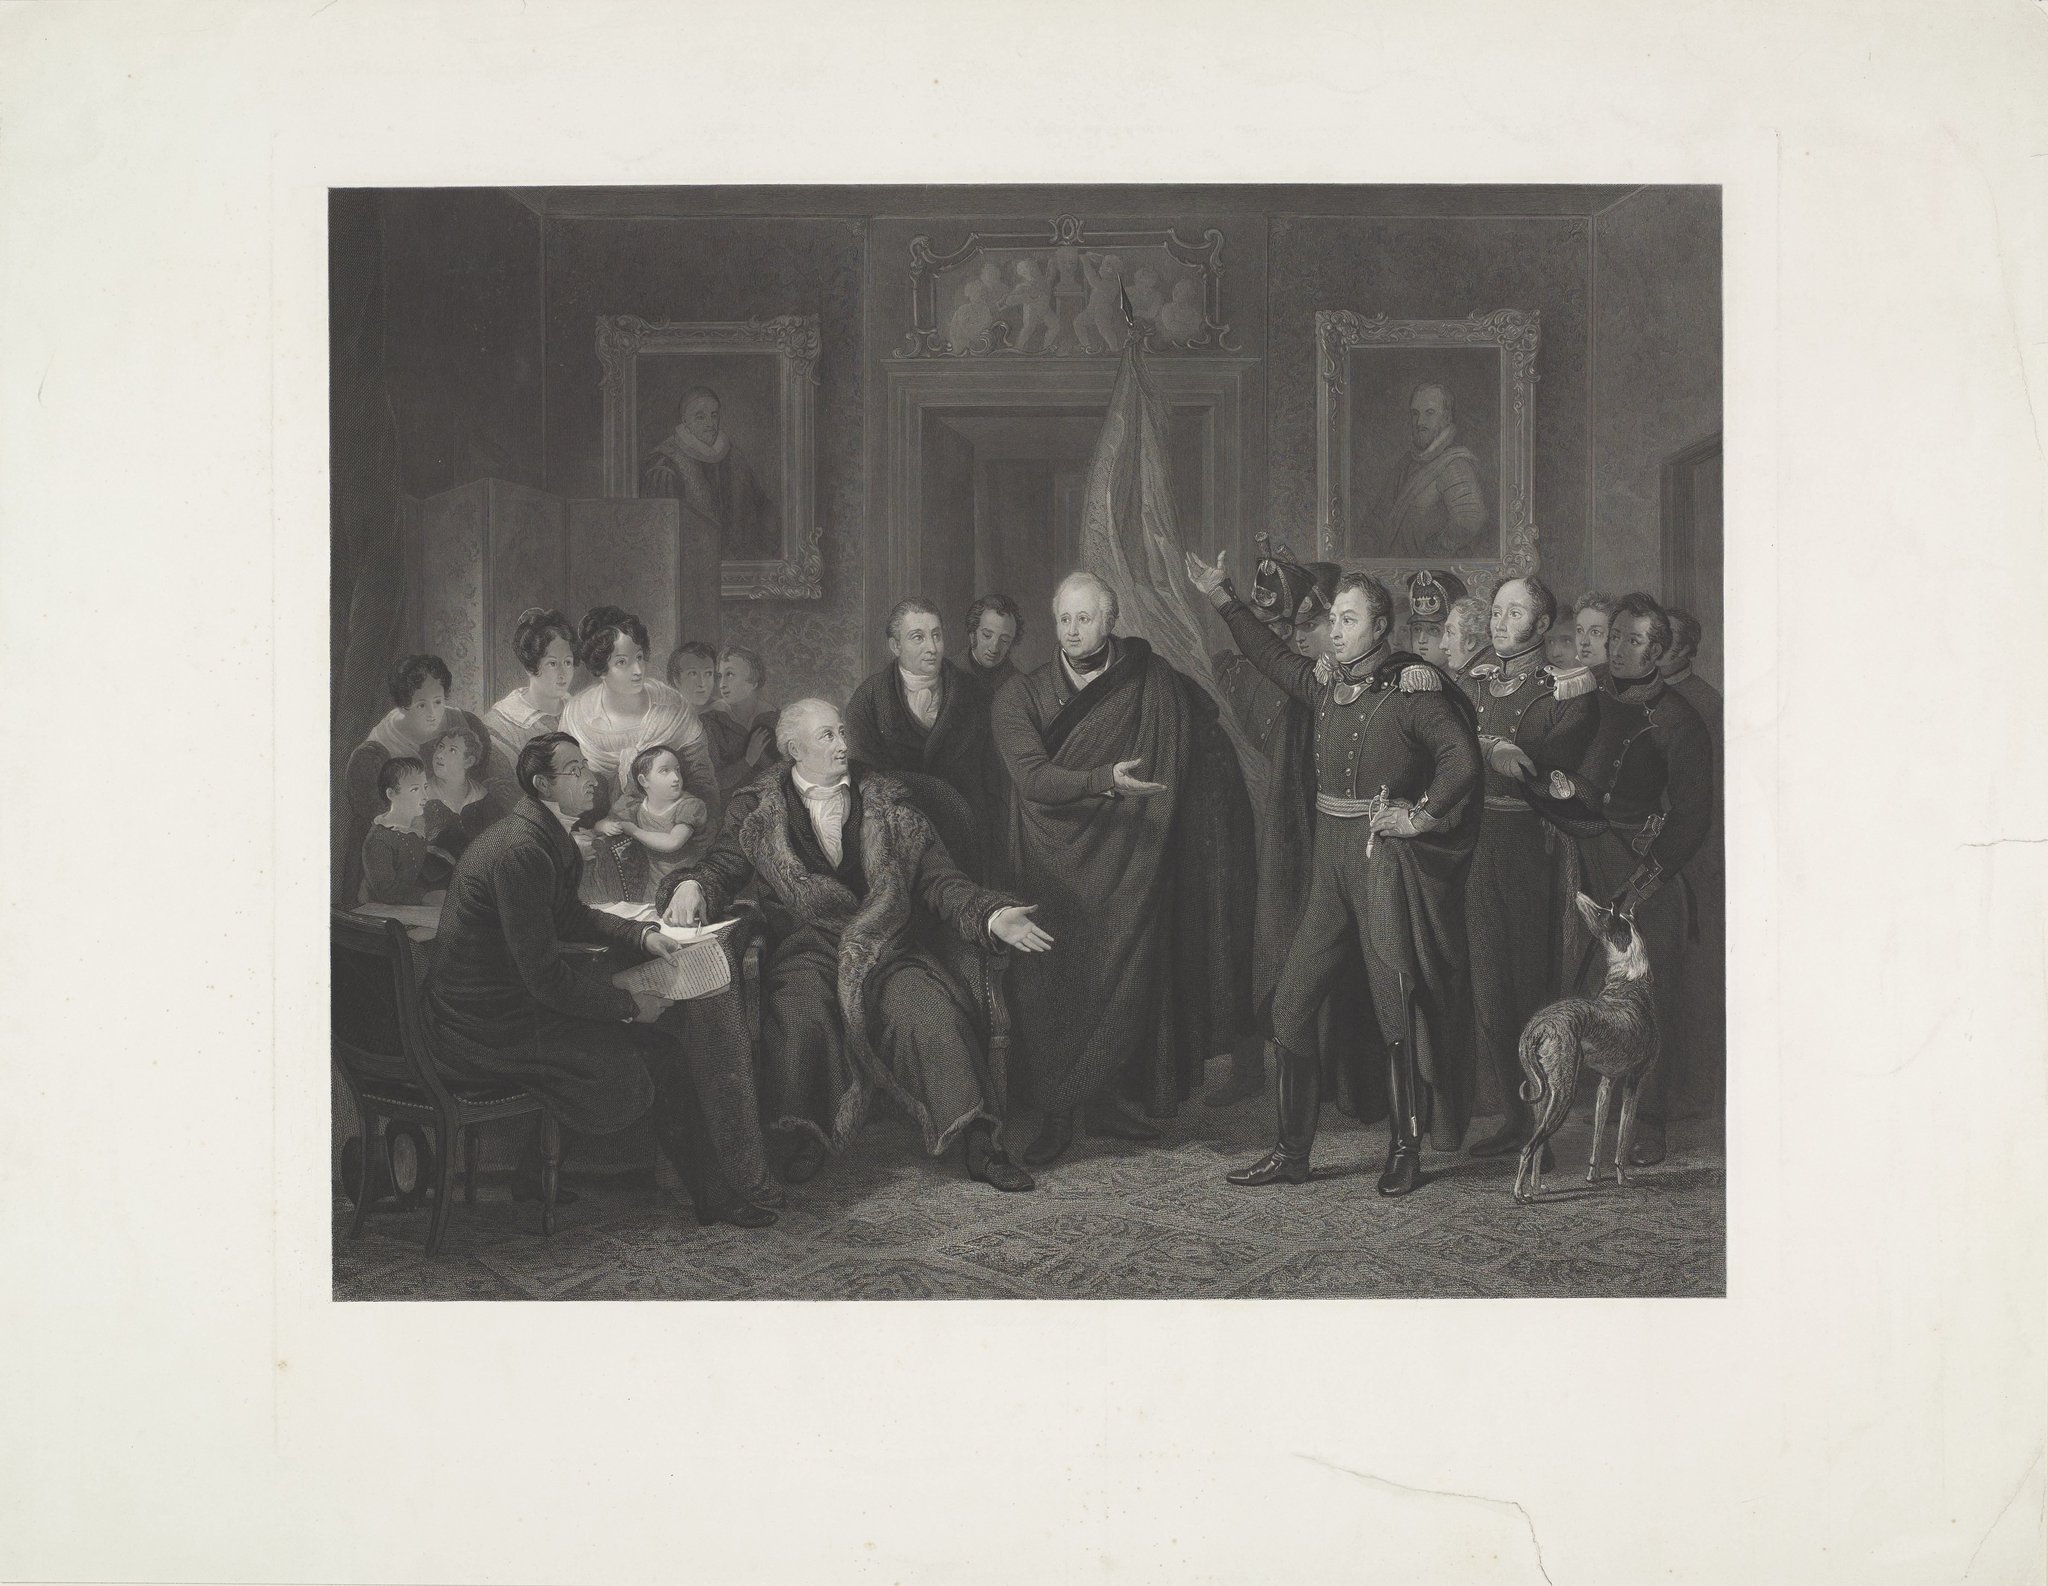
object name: history print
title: De aanvaarding van het Hoog Bewind door het Driemanschap in naam van de prins van Oranje, 21 november 1813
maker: dirk jurriaan sluyter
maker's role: draughtsman, print maker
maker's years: 1811-1886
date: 1863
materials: paper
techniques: aquatint, engraving, etching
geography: amsterdam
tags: berlin, william i of the netherlands, rotterdam, the hague, gijsbert karel graaf van hogendorp, deventer, adam françois jules armand van der duyn, transfer of power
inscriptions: collector's mark: Lugt 12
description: De aanvaarding van het Hoog Bewind door het Driemanschap in naam van de prins van Oranje op 21 november 1813 ten huize van Gijsbert Karel van Hogendorp, zittend rechts van de tafel. Achter hem staat Van der Duyn van Maasdam en naast hem staat, wijzend naar de officieren, Graaf van Limburg Stirum. Rechts staat met opgeheven hand kolonel Van Oldebarnevelt, genaamd Witte Tullingh, achter hem kapitien Van Heynsbergen. Zittend links aan tafel is Elias Canneman, achter hem vrouwen met kinderen. Aan de wand twee schilderijen met portretten van Willem van Oranje en Maurits. Bij de prent behoort een aparte bericht van intekening. De prent uitgegeven in 1863 bij het eerste halve eeuwfeest.